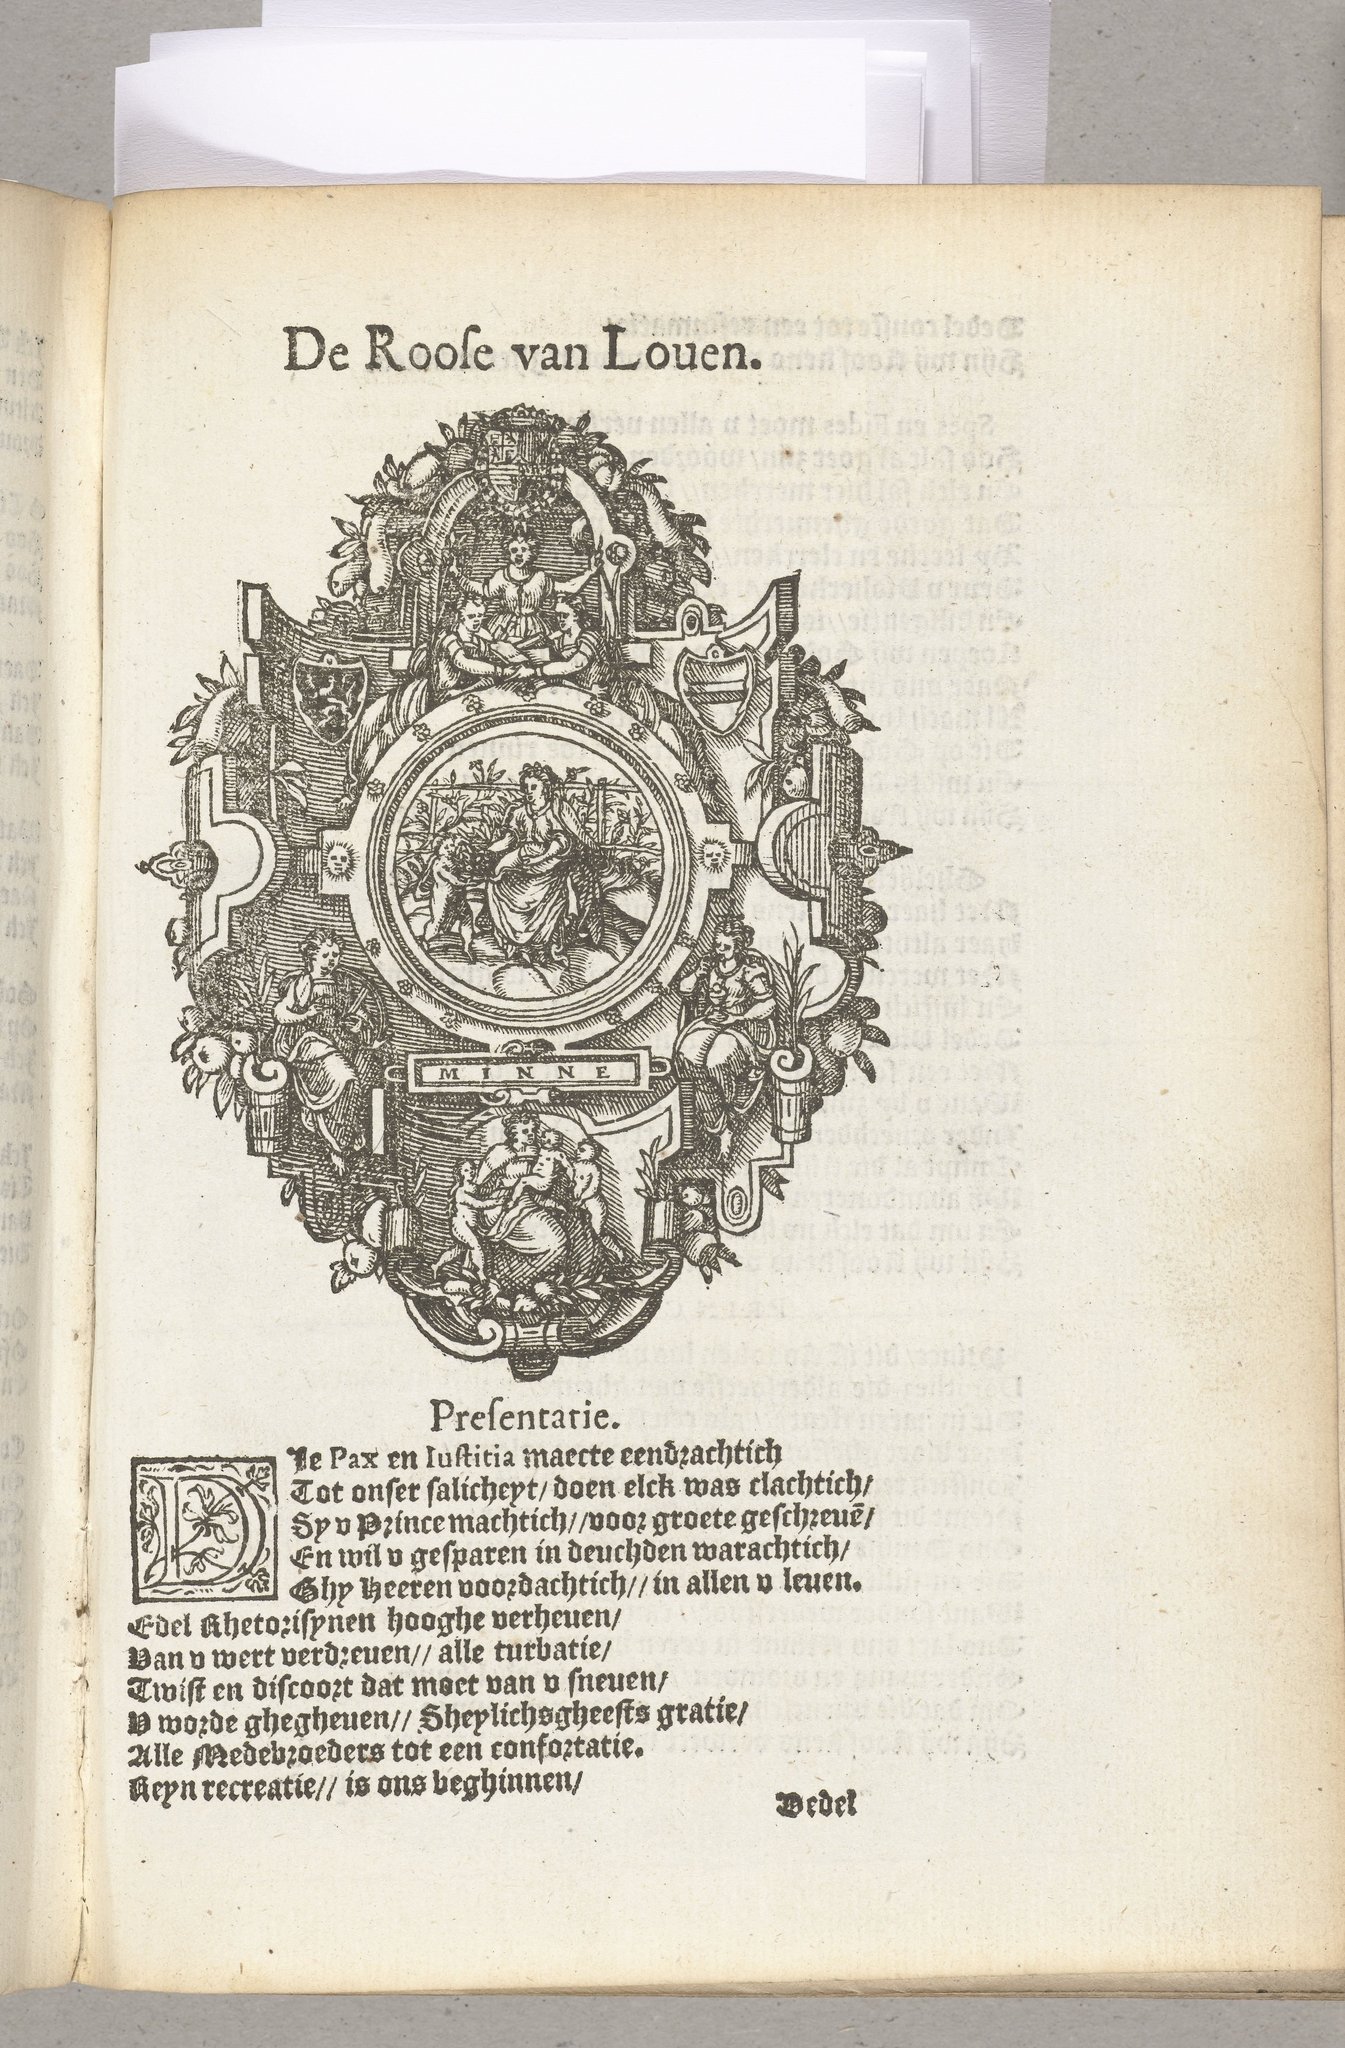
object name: print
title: De Roose van Loven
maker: Anonymous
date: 1561-1562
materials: paper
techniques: woodcut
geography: antwerp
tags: chamber of rhetoric (dutch: 'rederijkerskamer'), antwerp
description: Illustratie in: Spelen van sinne vol scoone moralisacien wtleggingen ende bediedenissen op alle loeflijcke consten waer inne men claerlijck ghelijck in eene spieghel, figuerlijck, poetelijck en retorijckelijck mach aenschouwen hoe nootsakelijck ende dienstelijck die selve consten allen menschen zijn : ghespeelt met octroy der Con. Ma. binnen der stadt van Andtwerpen op dLant-Juweel by die veerthien cameren van Retorijcken die hen daer ghepresenteert hebben den derden dach Augusti int Jaer ons Heeren 1561, op die questie : wat den mensch aldermeest tot conste verwect. Uitgave van 1562, p. d (4). In het exemplaar in de Rijksmuseum Research Library, signatuur: 325 D 20.